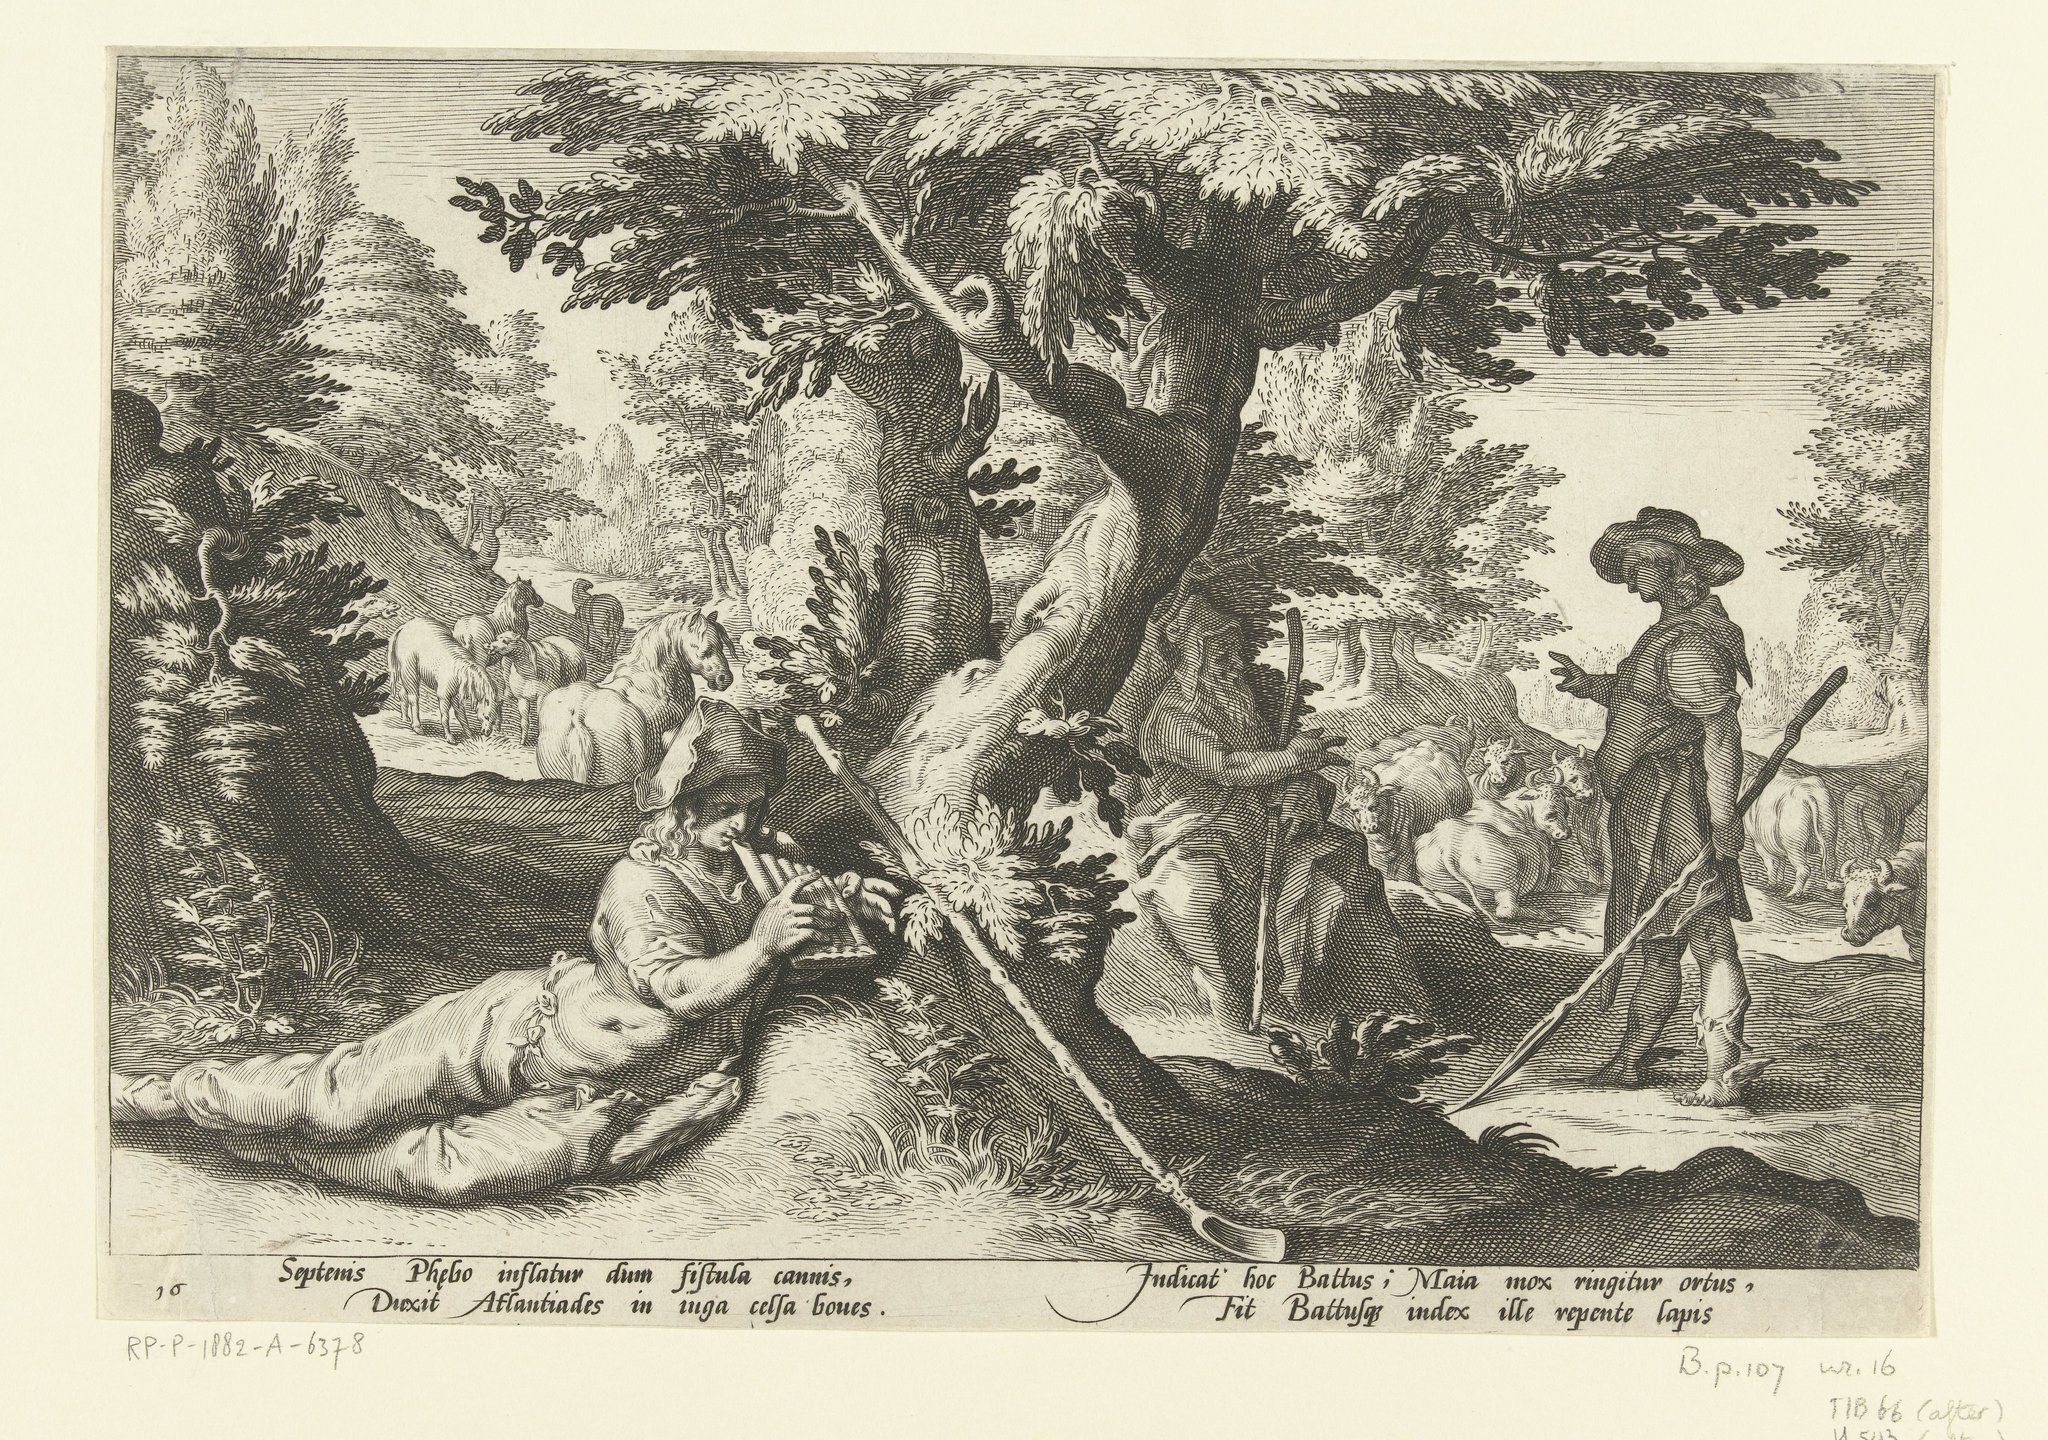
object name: print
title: Ovidius' Metamorfosen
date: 1590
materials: paper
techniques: engraving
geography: haarlem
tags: mercury steals the flock which apollo is tending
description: De oude man Battus had Mercurius beloofd niemand te verraden waar zich de runderen bevonden die laatstgenoemde had gestolen van Apollo. Maar toen Mercurius hem er in een andere gedaante naar vroeg, zei hij het toch. Daarop veranderde de god Battus in een steen. Op de prent staat Mercurius tegenover Battus; achter hen een kudde runderen. Op de voorgrond Apollo, spelend op een panfluit. Onder de voorstelling twee keer twee regels Latijnse tekst. Deze prent is onderdeel van een serie van 52 prenten die verhalen uit Ovidius' Metamorfosen verbeelden. Deze serie valt uiteen in drie genummerde reeksen: twee van 20 prenten en één van 12 prenten. Deze prent behoort tot de tweede reeks.